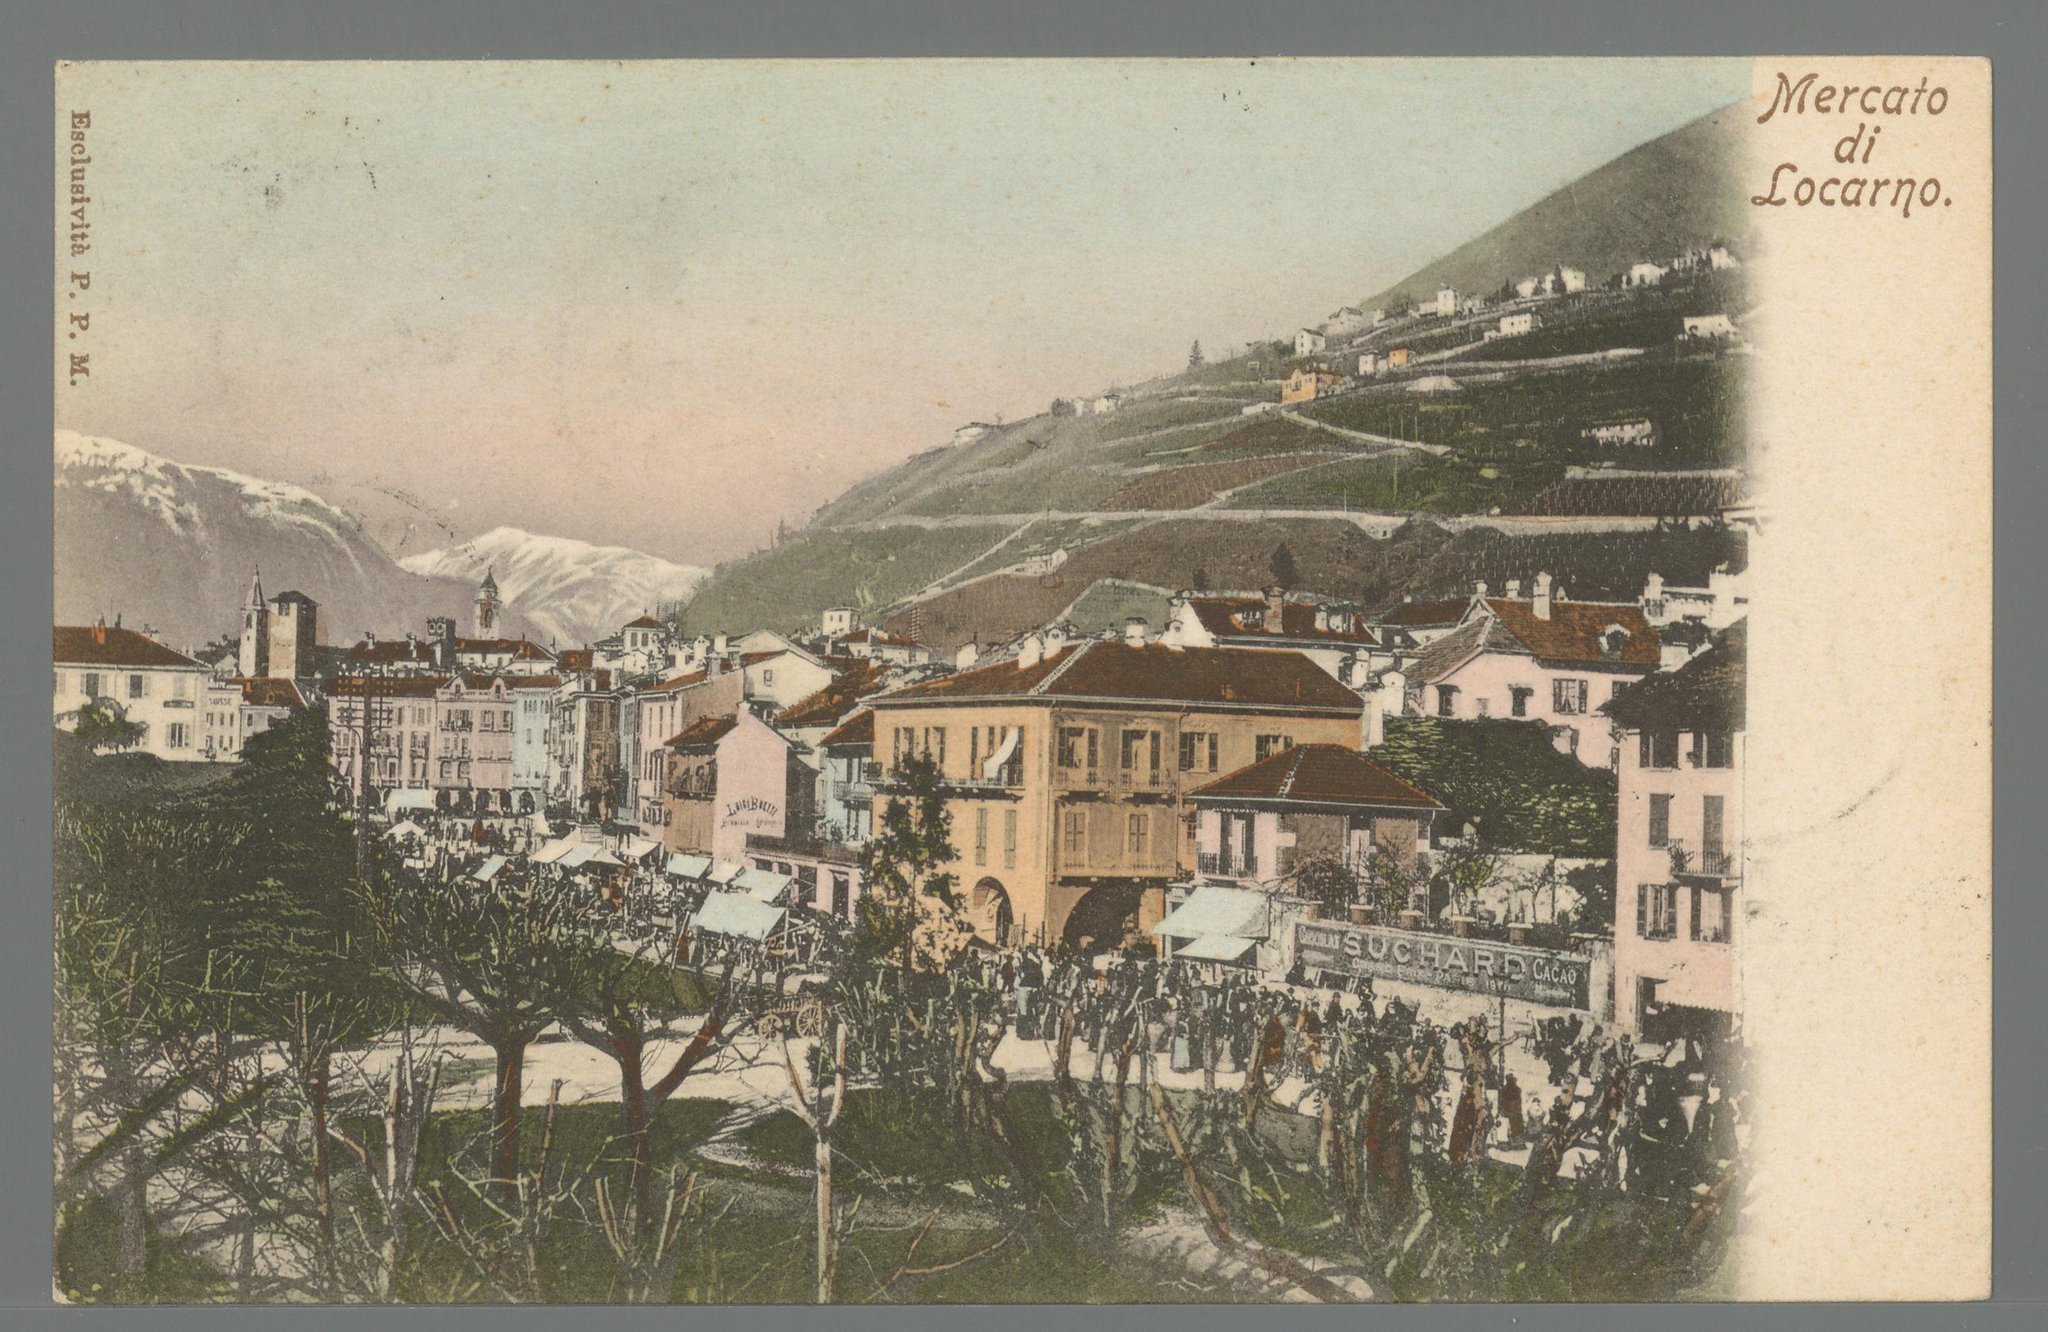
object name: photomechanical print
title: Mercato di Locarno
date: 1890-1902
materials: cardboard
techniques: photograph, lithograph, writing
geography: locarno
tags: mountain-range, snow peaks, prospect of city, town panorama, silhouette of city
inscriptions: postage stamp